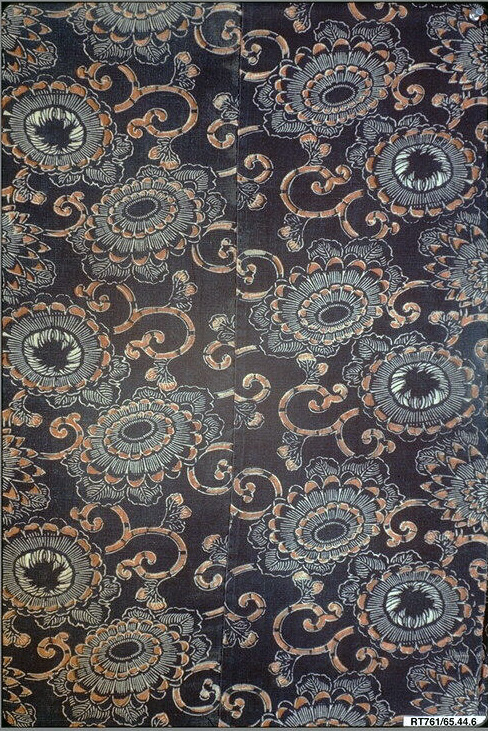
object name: strip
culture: japanese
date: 1801-1900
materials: cotton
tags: flowers